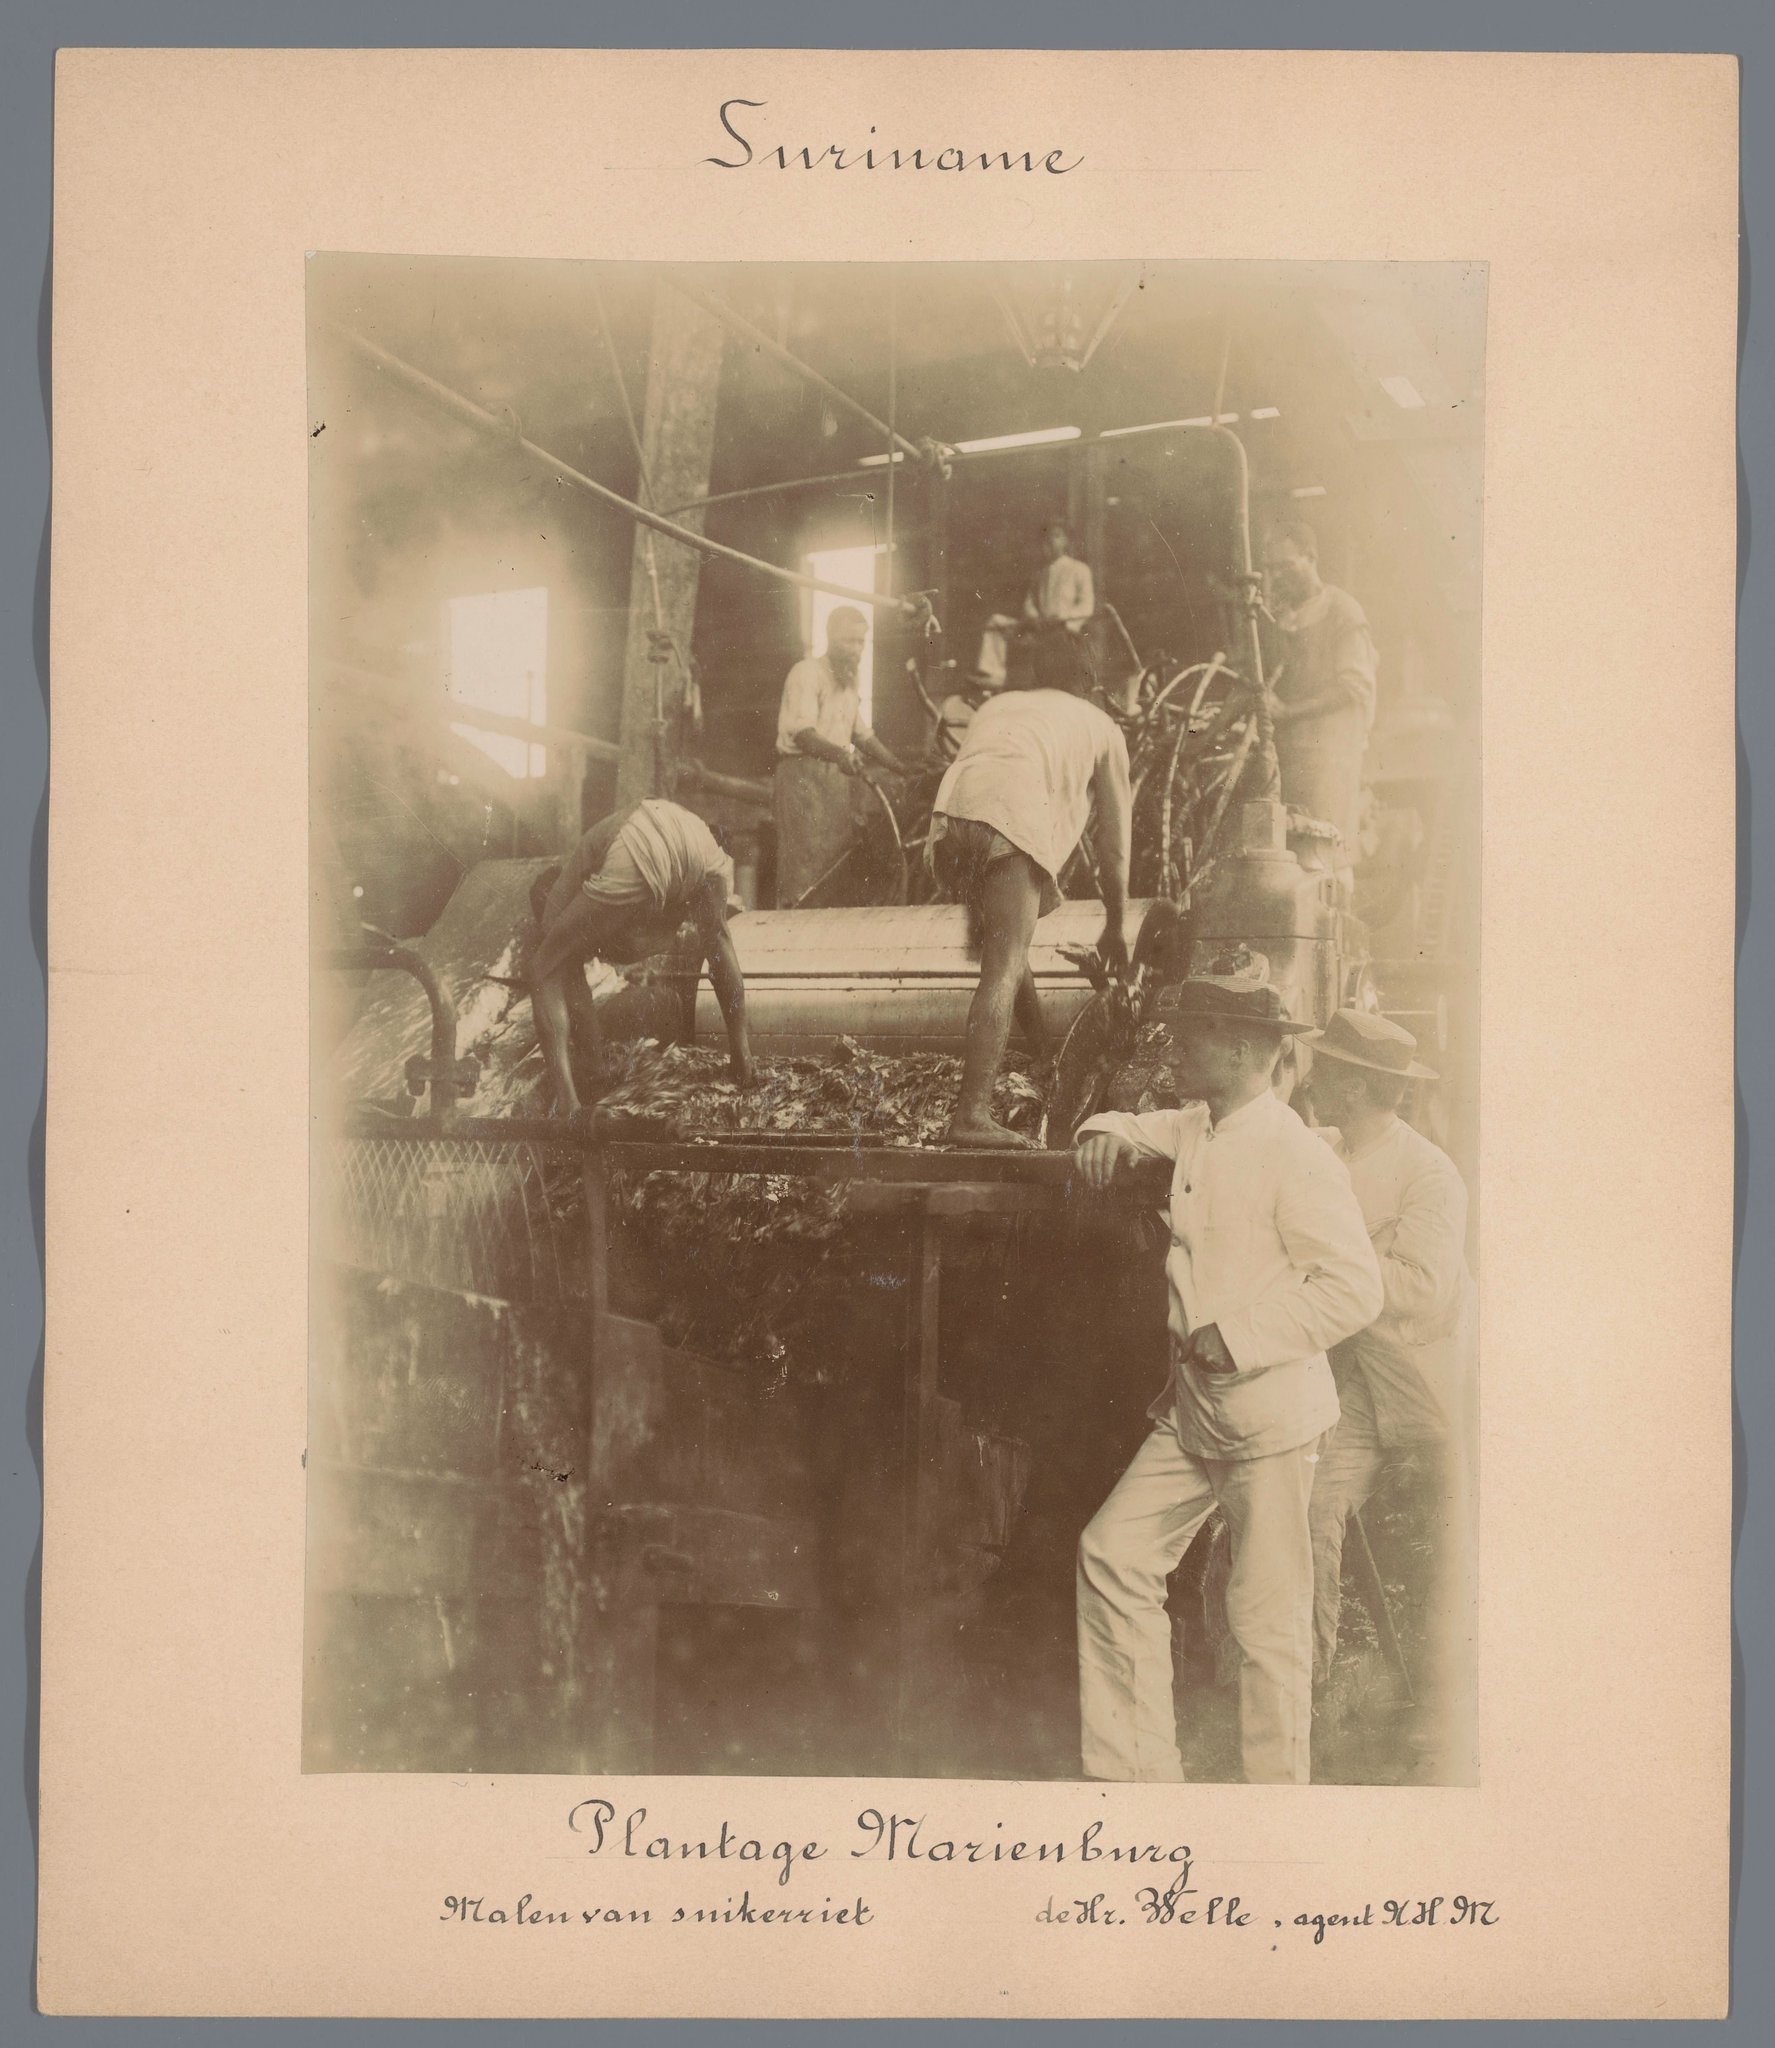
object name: photograph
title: Plantage Marienburg / Malen van suikerriet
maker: eugen klein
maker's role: fotograaf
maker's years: 1869-1927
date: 1900-1905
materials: cardboard, photographic support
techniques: gelatin silver print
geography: suriname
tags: suriname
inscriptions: inscription: ‘Suriname / Plantage Marienburg / Malen van suikerriet / de Hr. Welle, agent NHM’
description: Het vermalen van suikerriet in de suikerfabriek op de Plantage Mariënburg. Enkele arbeiders op en bij de maalmachine, op de voorgrond de heer Welle, agent van de Nederlandse Handelsmaatschappij. Onderdeel van een groep van 44 foto's van Paramaribo, Suriname en Curaçao, ca. 1900-1905, opgeplakt op kartons en voorzien van opschriften.